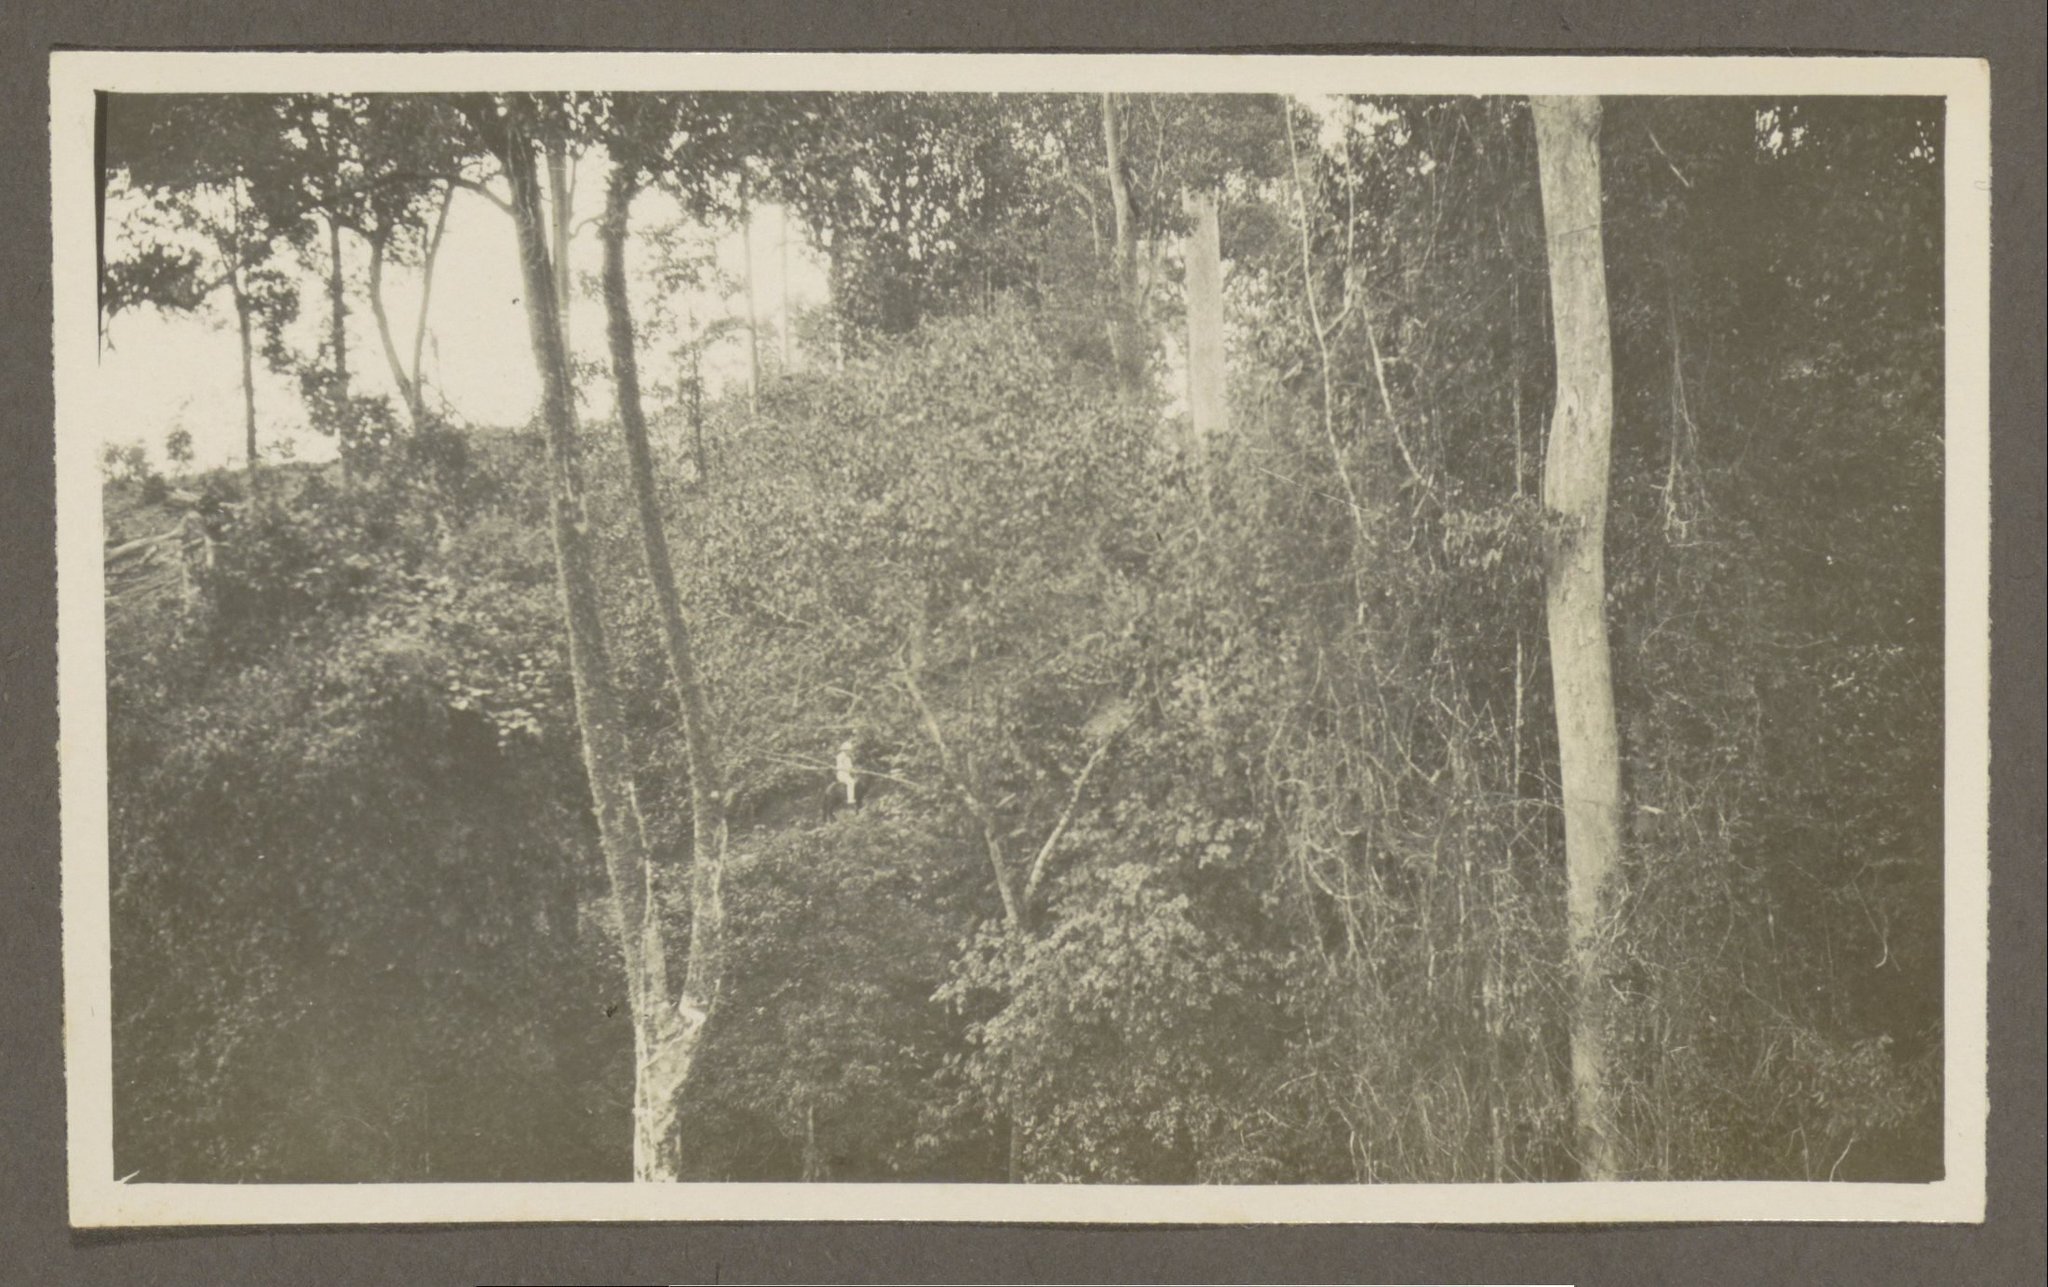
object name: photograph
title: Man in tropenkleding te paard op een berghelling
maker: Anonymous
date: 1920-1930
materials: photographic support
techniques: gelatin silver print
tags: riding a horse, ass, or mule; rider, horseman, dutch east indies, the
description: Onderdeel van familiealbum Nederlands-Indië.